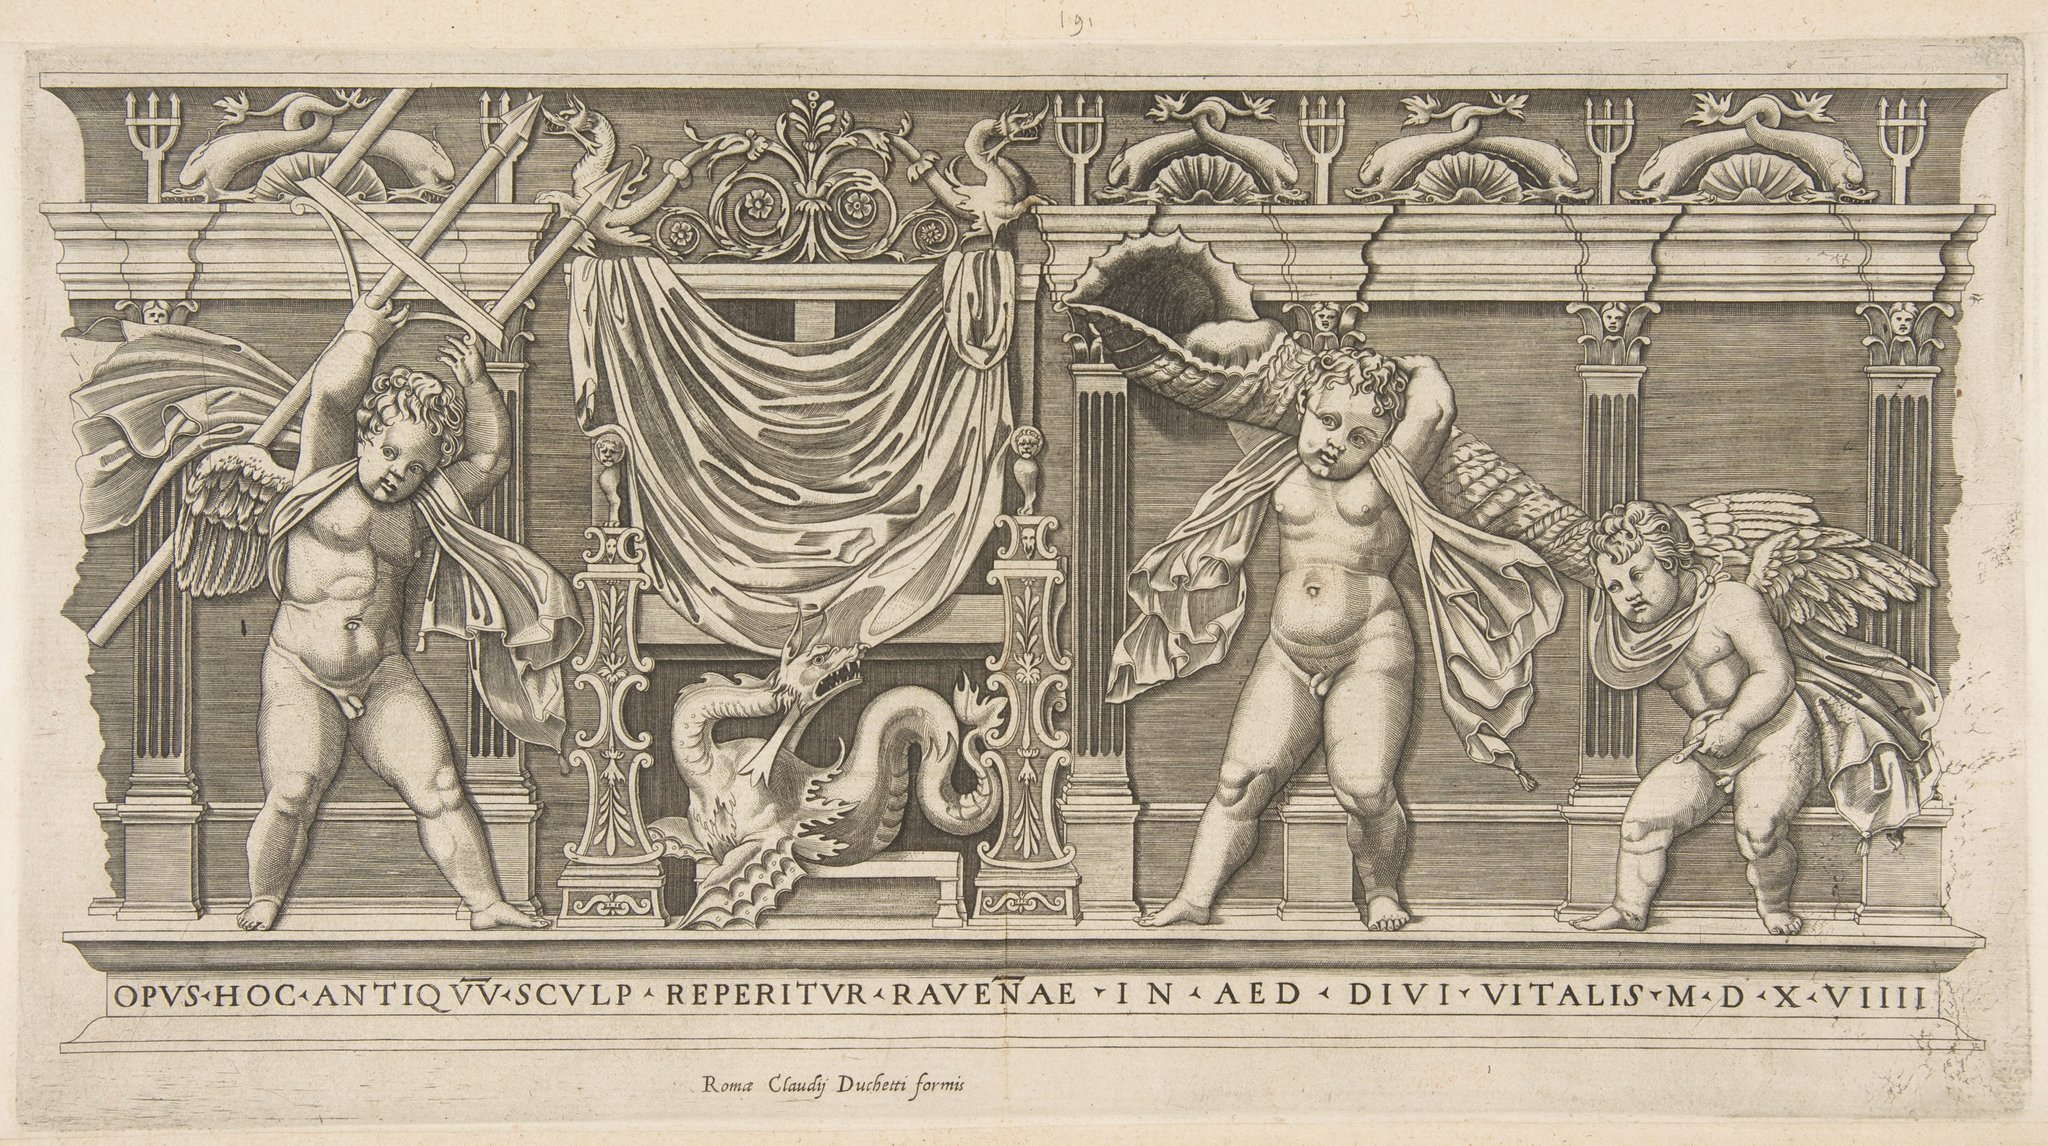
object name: print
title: Three cupids in front of a facade with pilasters, one holding a trident and another a large shell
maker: anonymous, italian, 16th to early 17th century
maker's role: artist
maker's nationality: italian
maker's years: 1500-1640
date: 1515-1600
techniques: engraving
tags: cupid,dragons